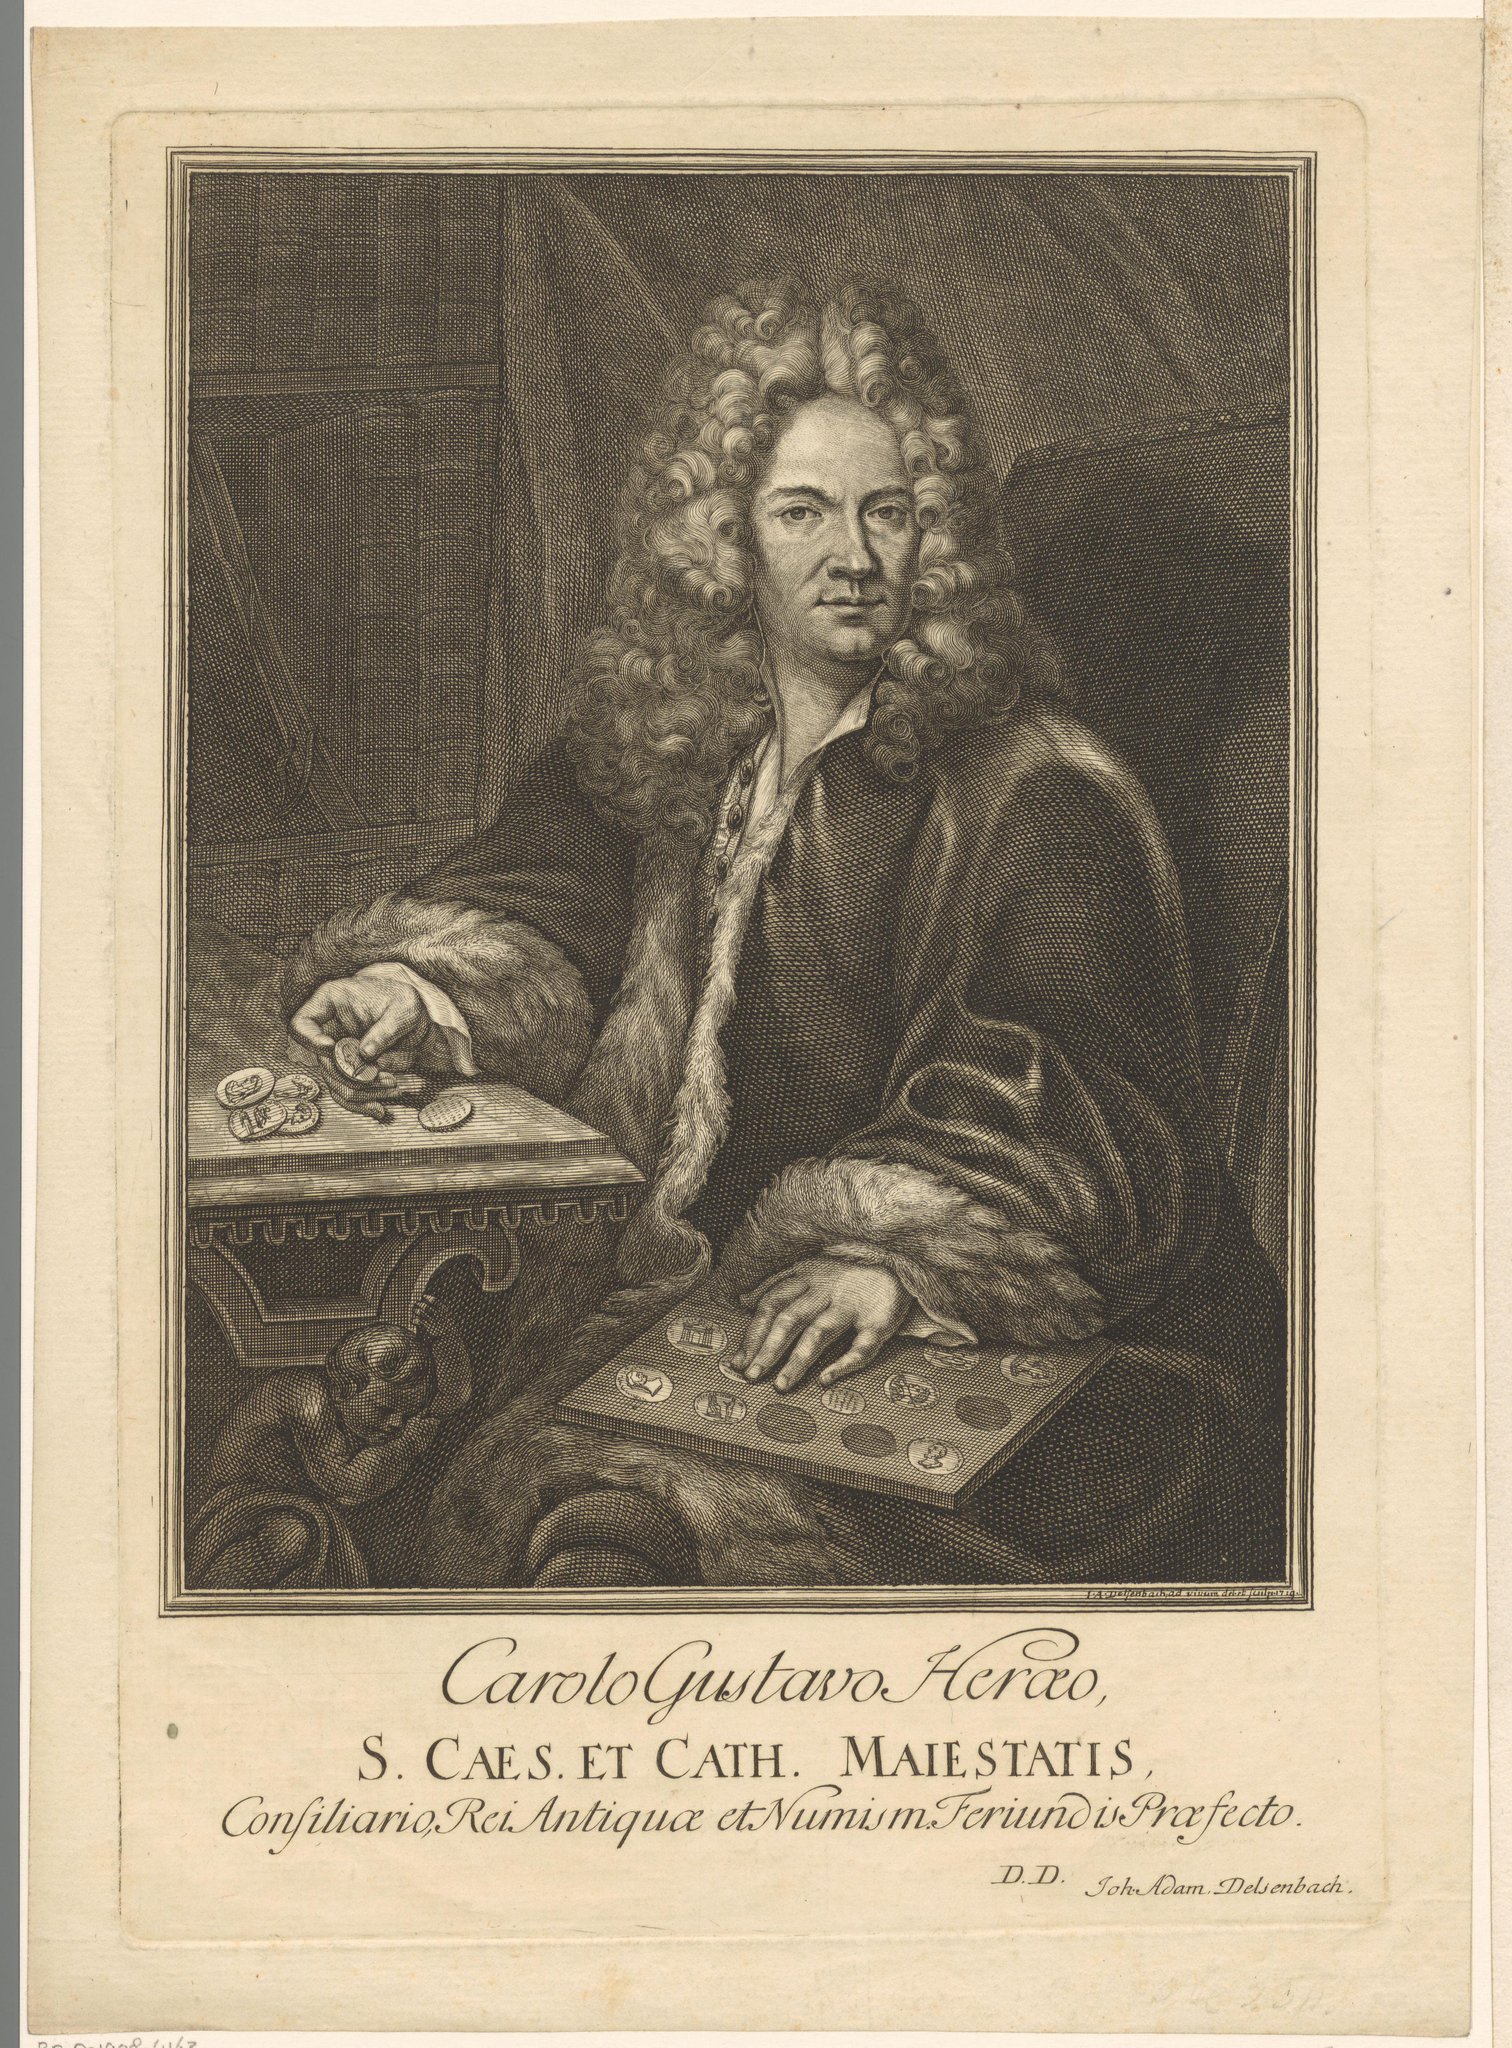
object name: print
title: Portret van Karl Gustav Heraeus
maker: johann adam delsenbach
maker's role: print maker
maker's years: 1687-1765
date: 1719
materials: paper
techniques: engraving, etching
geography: nuremberg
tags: collecting (leisure time activity), historical persons, coin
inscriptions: collector's mark: Lugt 2228